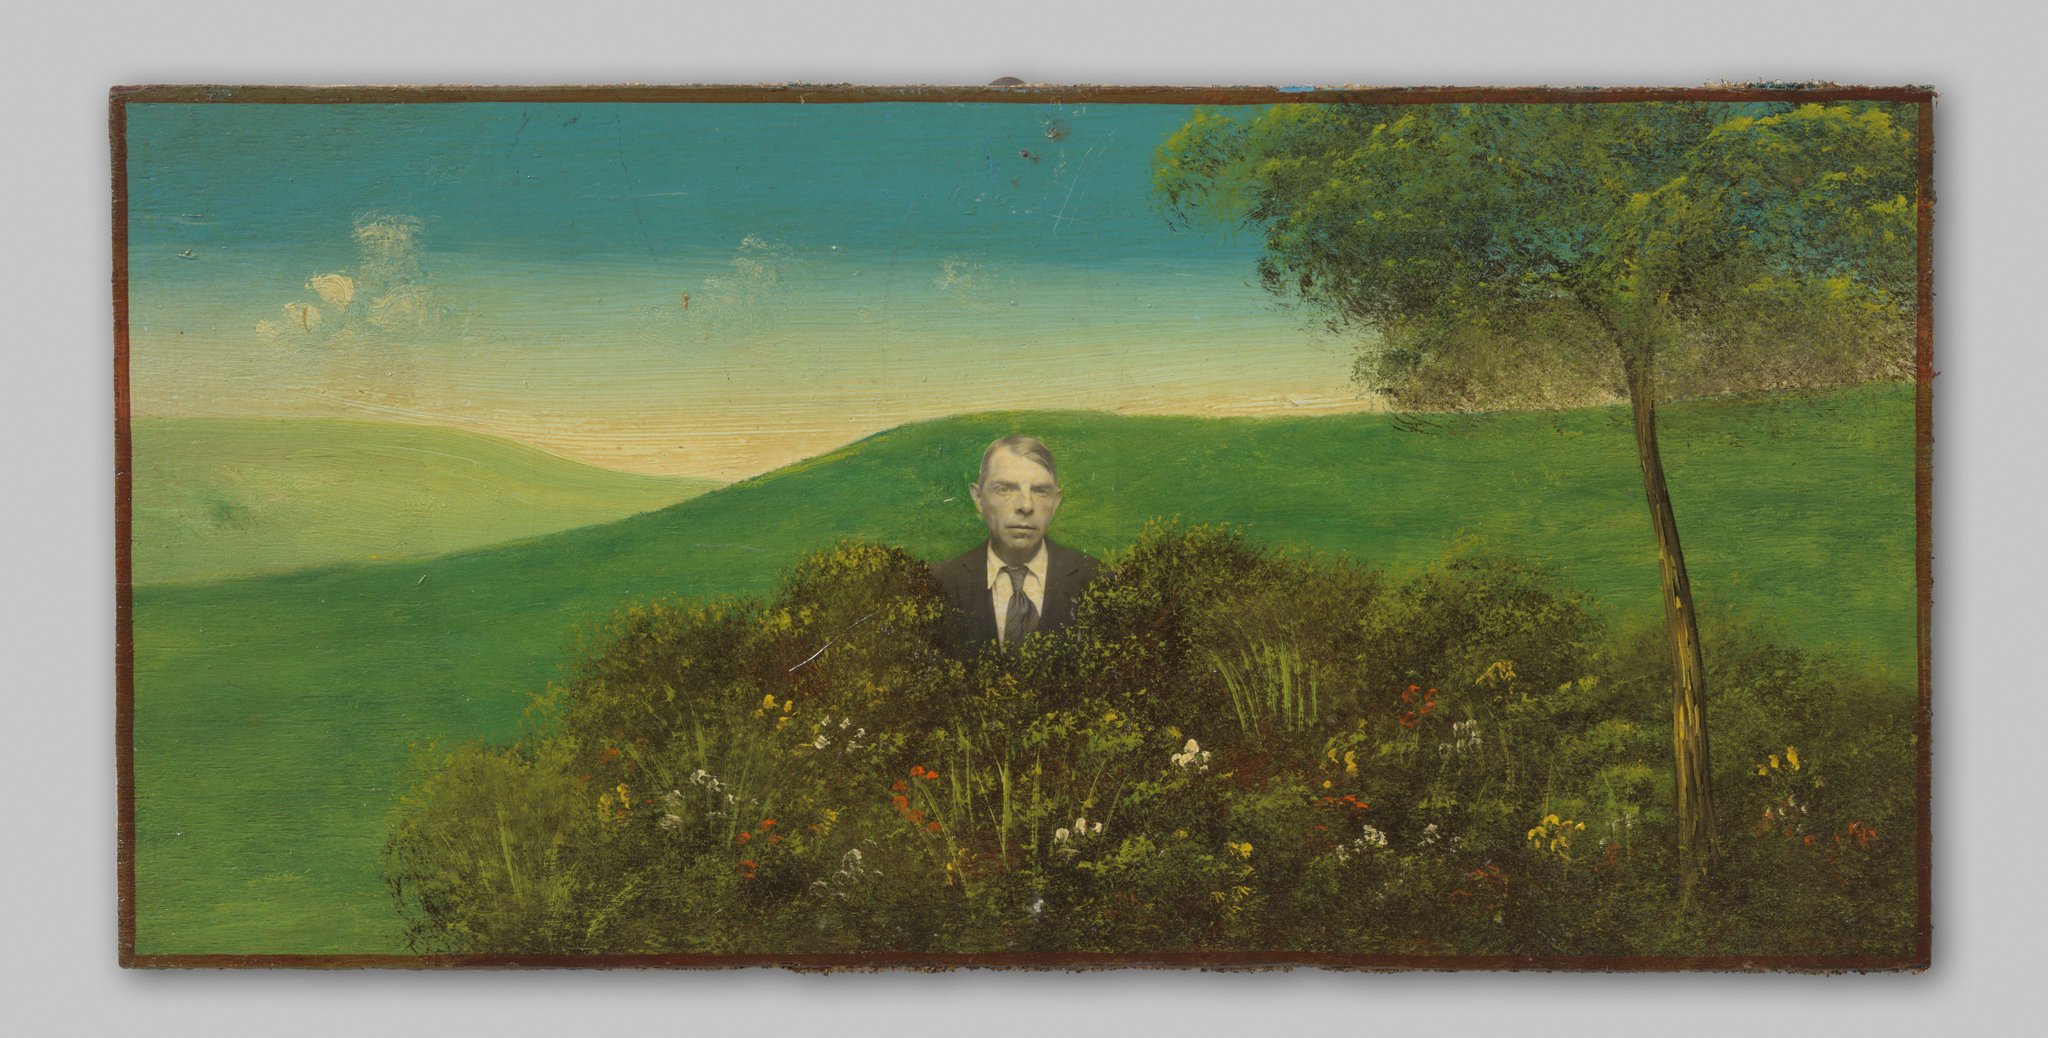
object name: photograph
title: Portret van een onbekende man in een geschilderd landschap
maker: Anonymous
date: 1910-1950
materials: metal, paint, paper, wood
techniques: albumen print, brush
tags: adult man, anonymous historical person portrayed, landscapes - hh - ideal landscapes